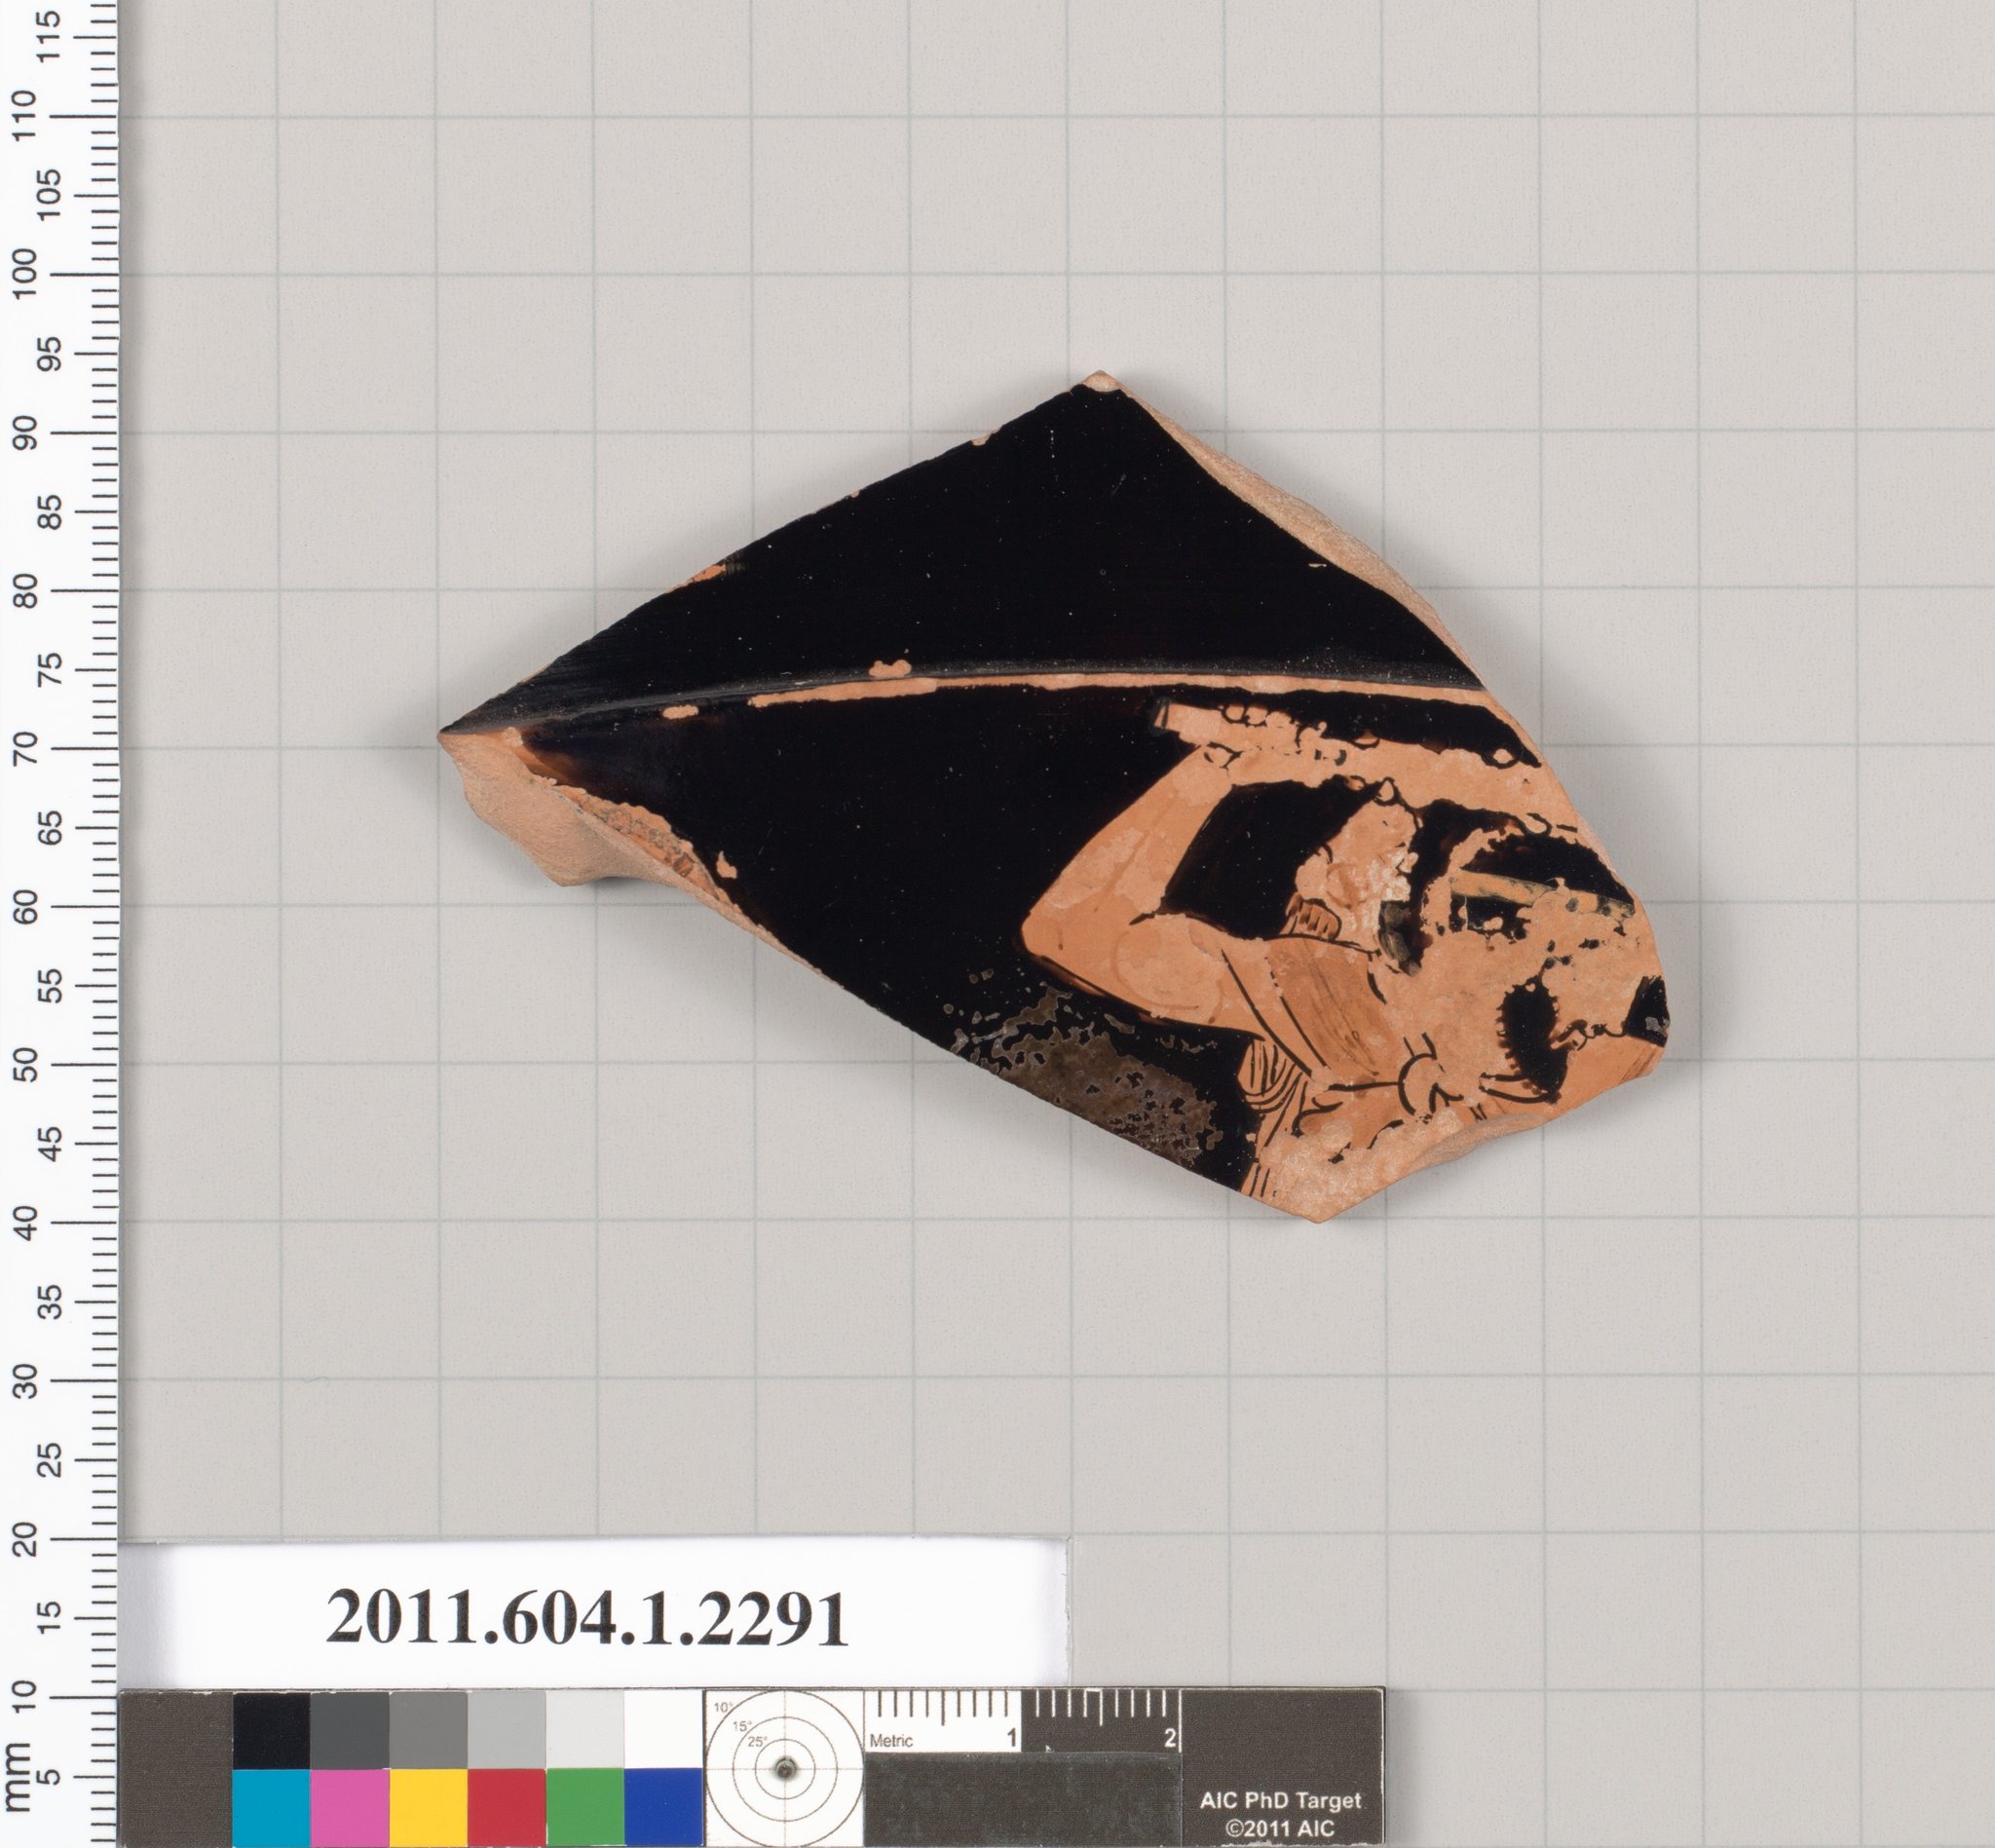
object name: kylix fragment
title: Terracotta fragment of a kylix (drinking cup)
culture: greek, attic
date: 475-451 BCE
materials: terracotta